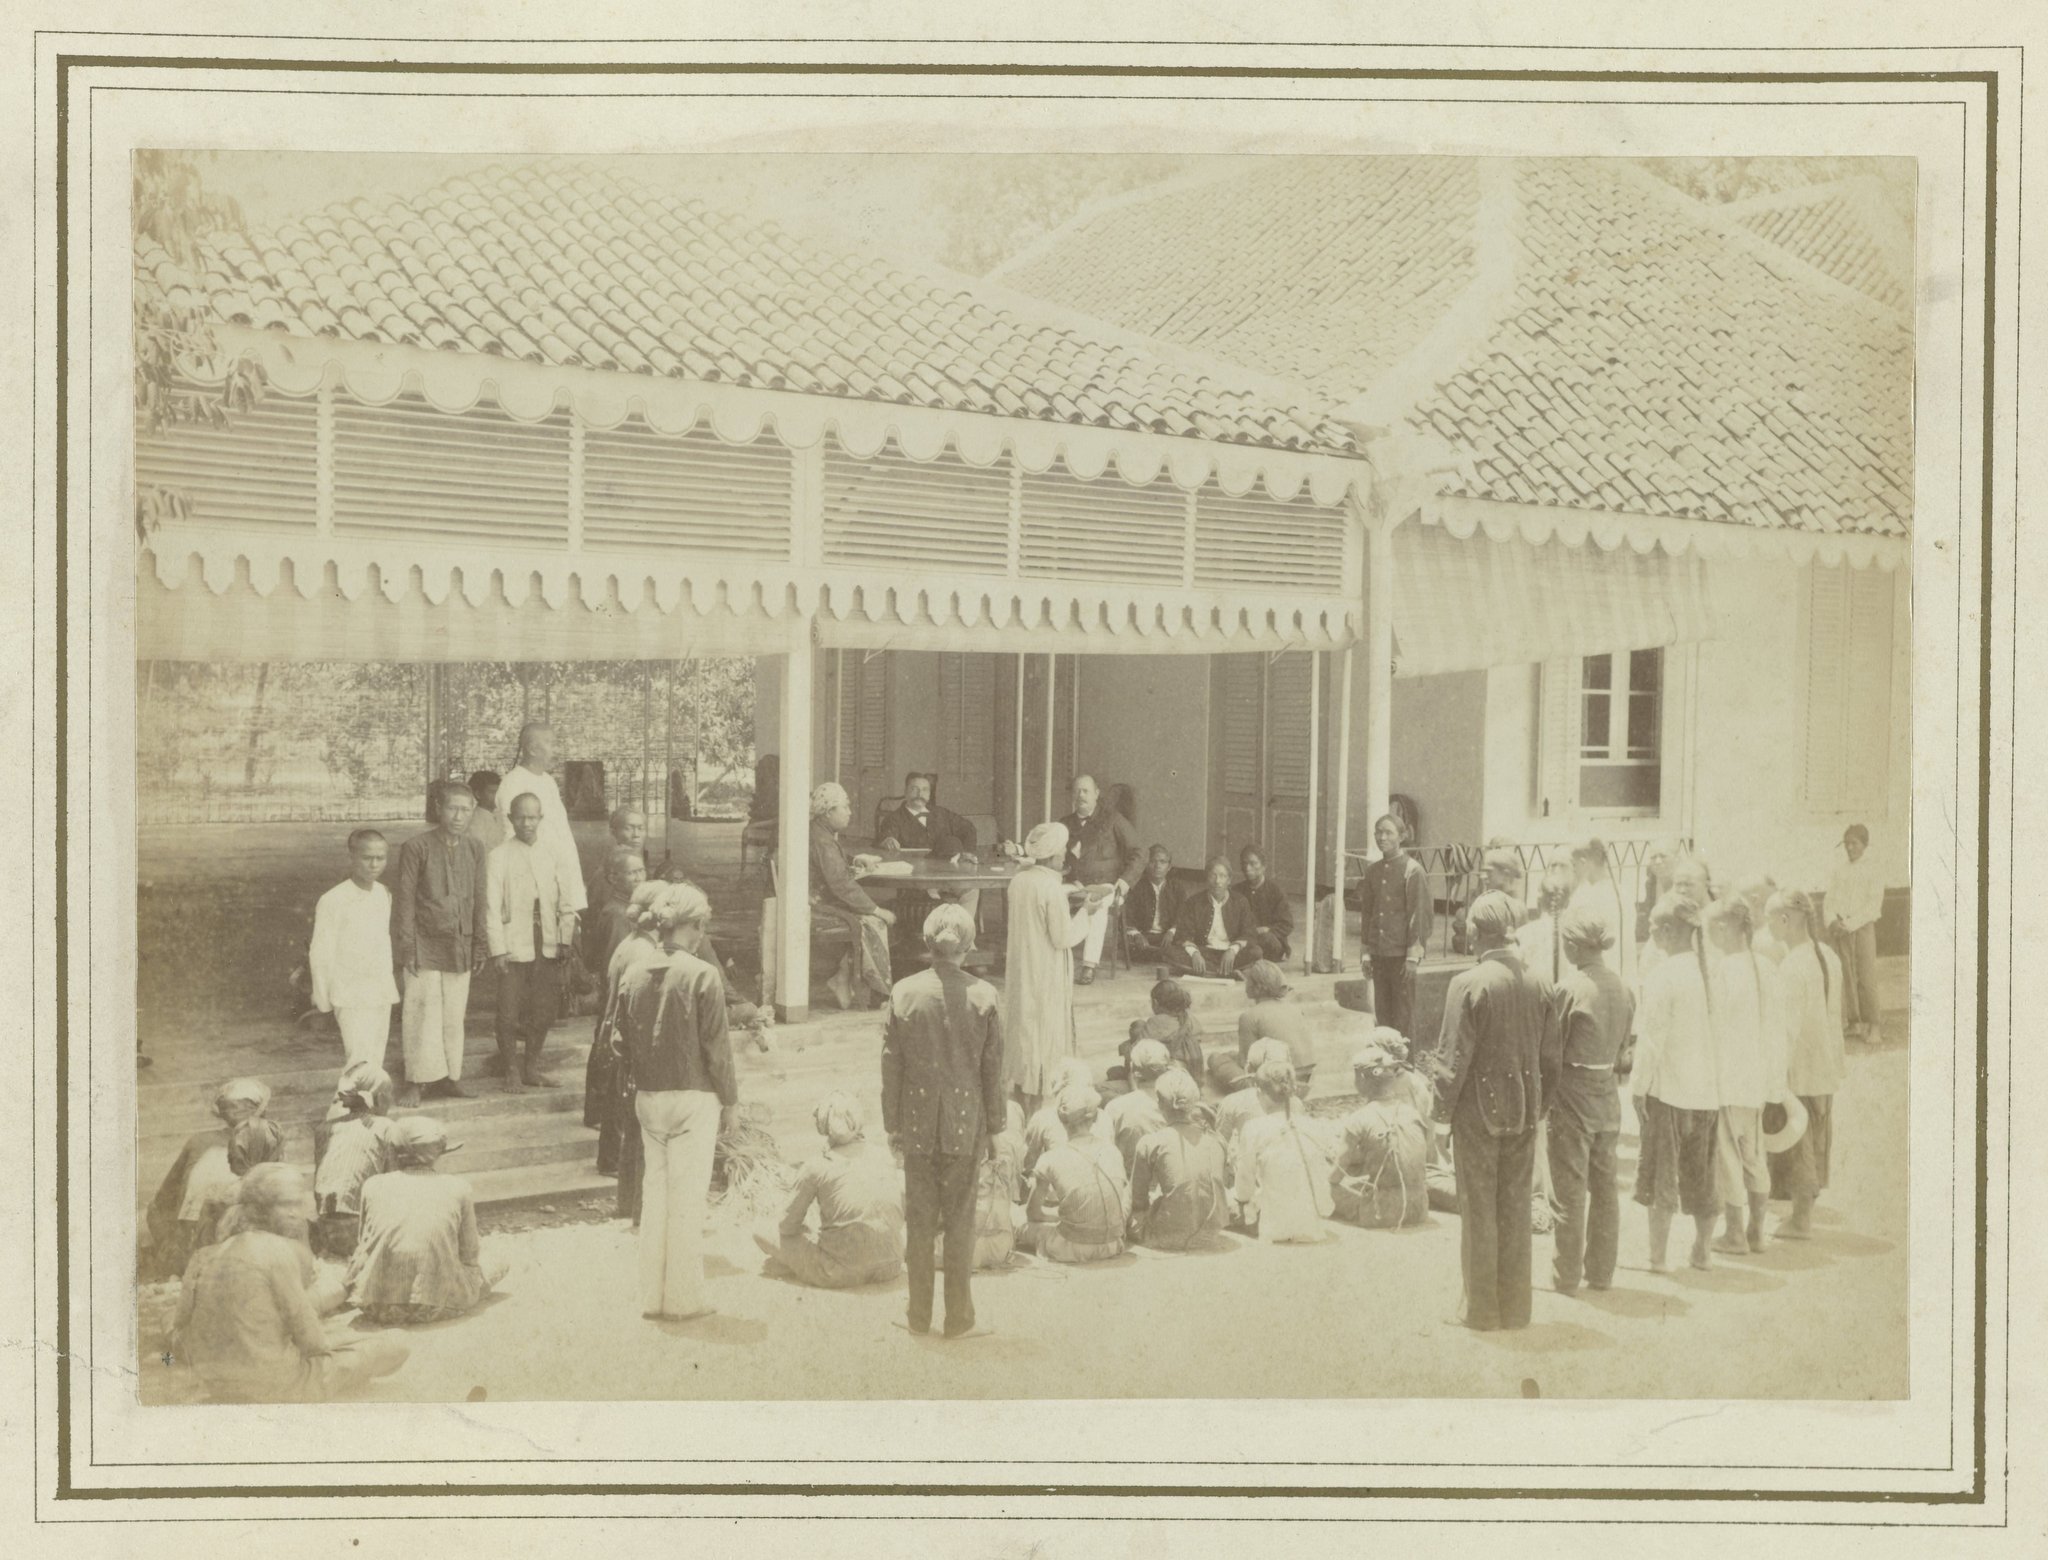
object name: photograph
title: Rechtszaak bij de assistent-resident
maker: kassian céphas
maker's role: fotograaf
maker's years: 1845-1912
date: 1886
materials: photographic support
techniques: albumen print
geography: jogjakarta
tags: the hague, colonial system, court session (court of justice), colonial government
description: Een rechtszaak onder het bestuur van de assistent-resident. Een islamitische rechter neemt de verdachten de eed op de Koran af. Onderdeel van het fotoalbum aangeboden aan J.M. Pijnacker Hordijk bij zijn vertrek uit Jogyakarta in 1886.